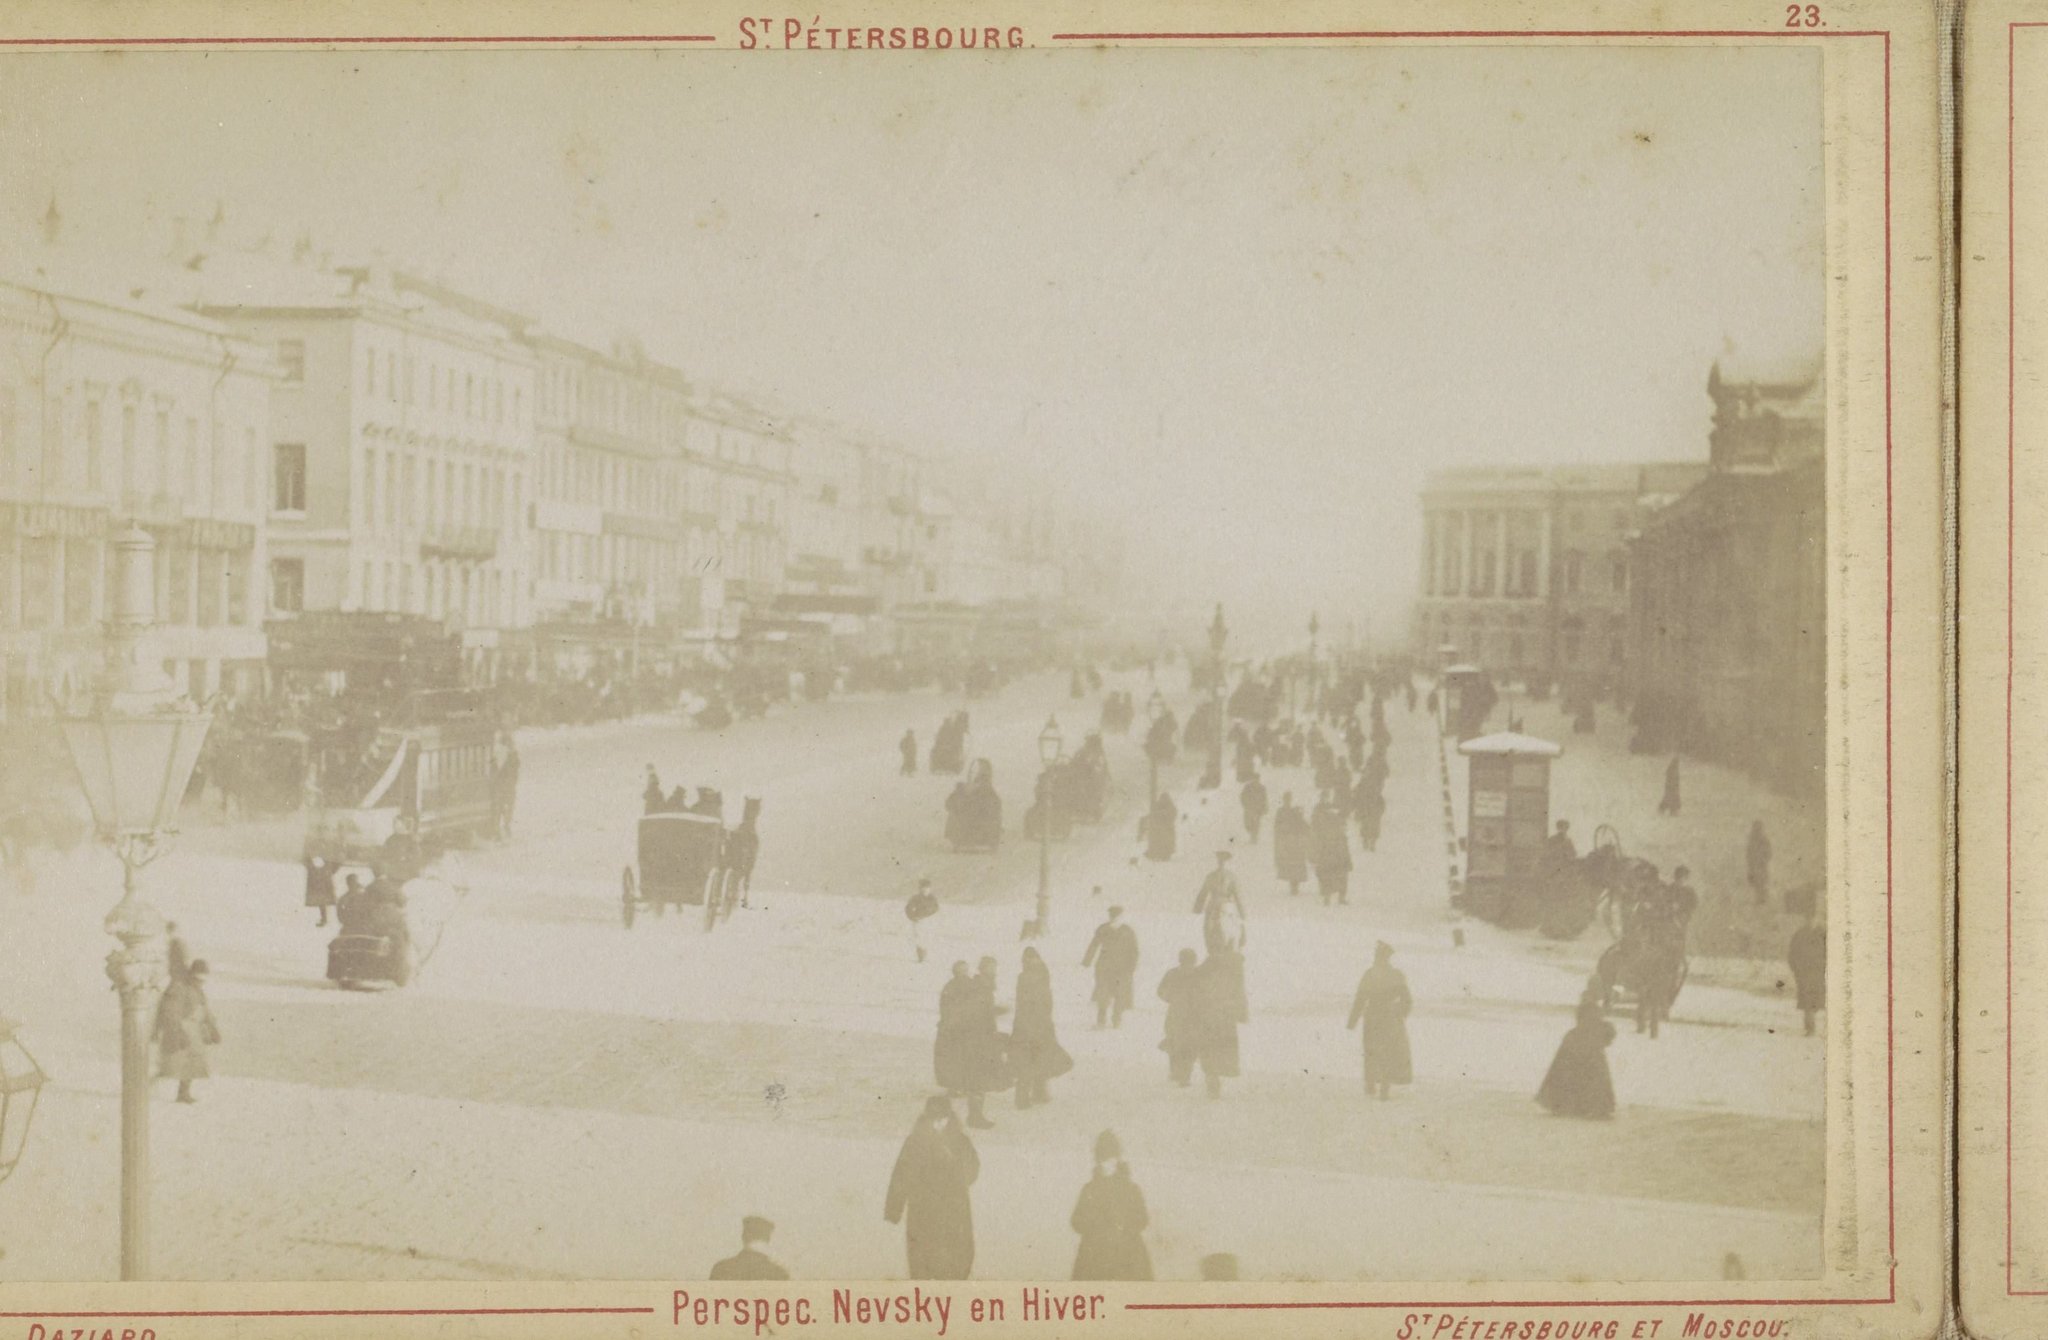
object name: photograph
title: Gezicht op Nevsky Prospekt in winters Sint-Petersburg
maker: joseph daziaro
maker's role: publisher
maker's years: 1831-1892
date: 1880-1900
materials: cardboard, photographic support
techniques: albumen print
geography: sint-petersburg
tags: winter landscape; landscape symbolizing winter (the four seasons of the year), snow, street (+ city(-scape) with figures, staffage)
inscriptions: inscription: ‘23.’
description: Onderdeel van Leporelloalbum met opnames van Sint-Petersburg.